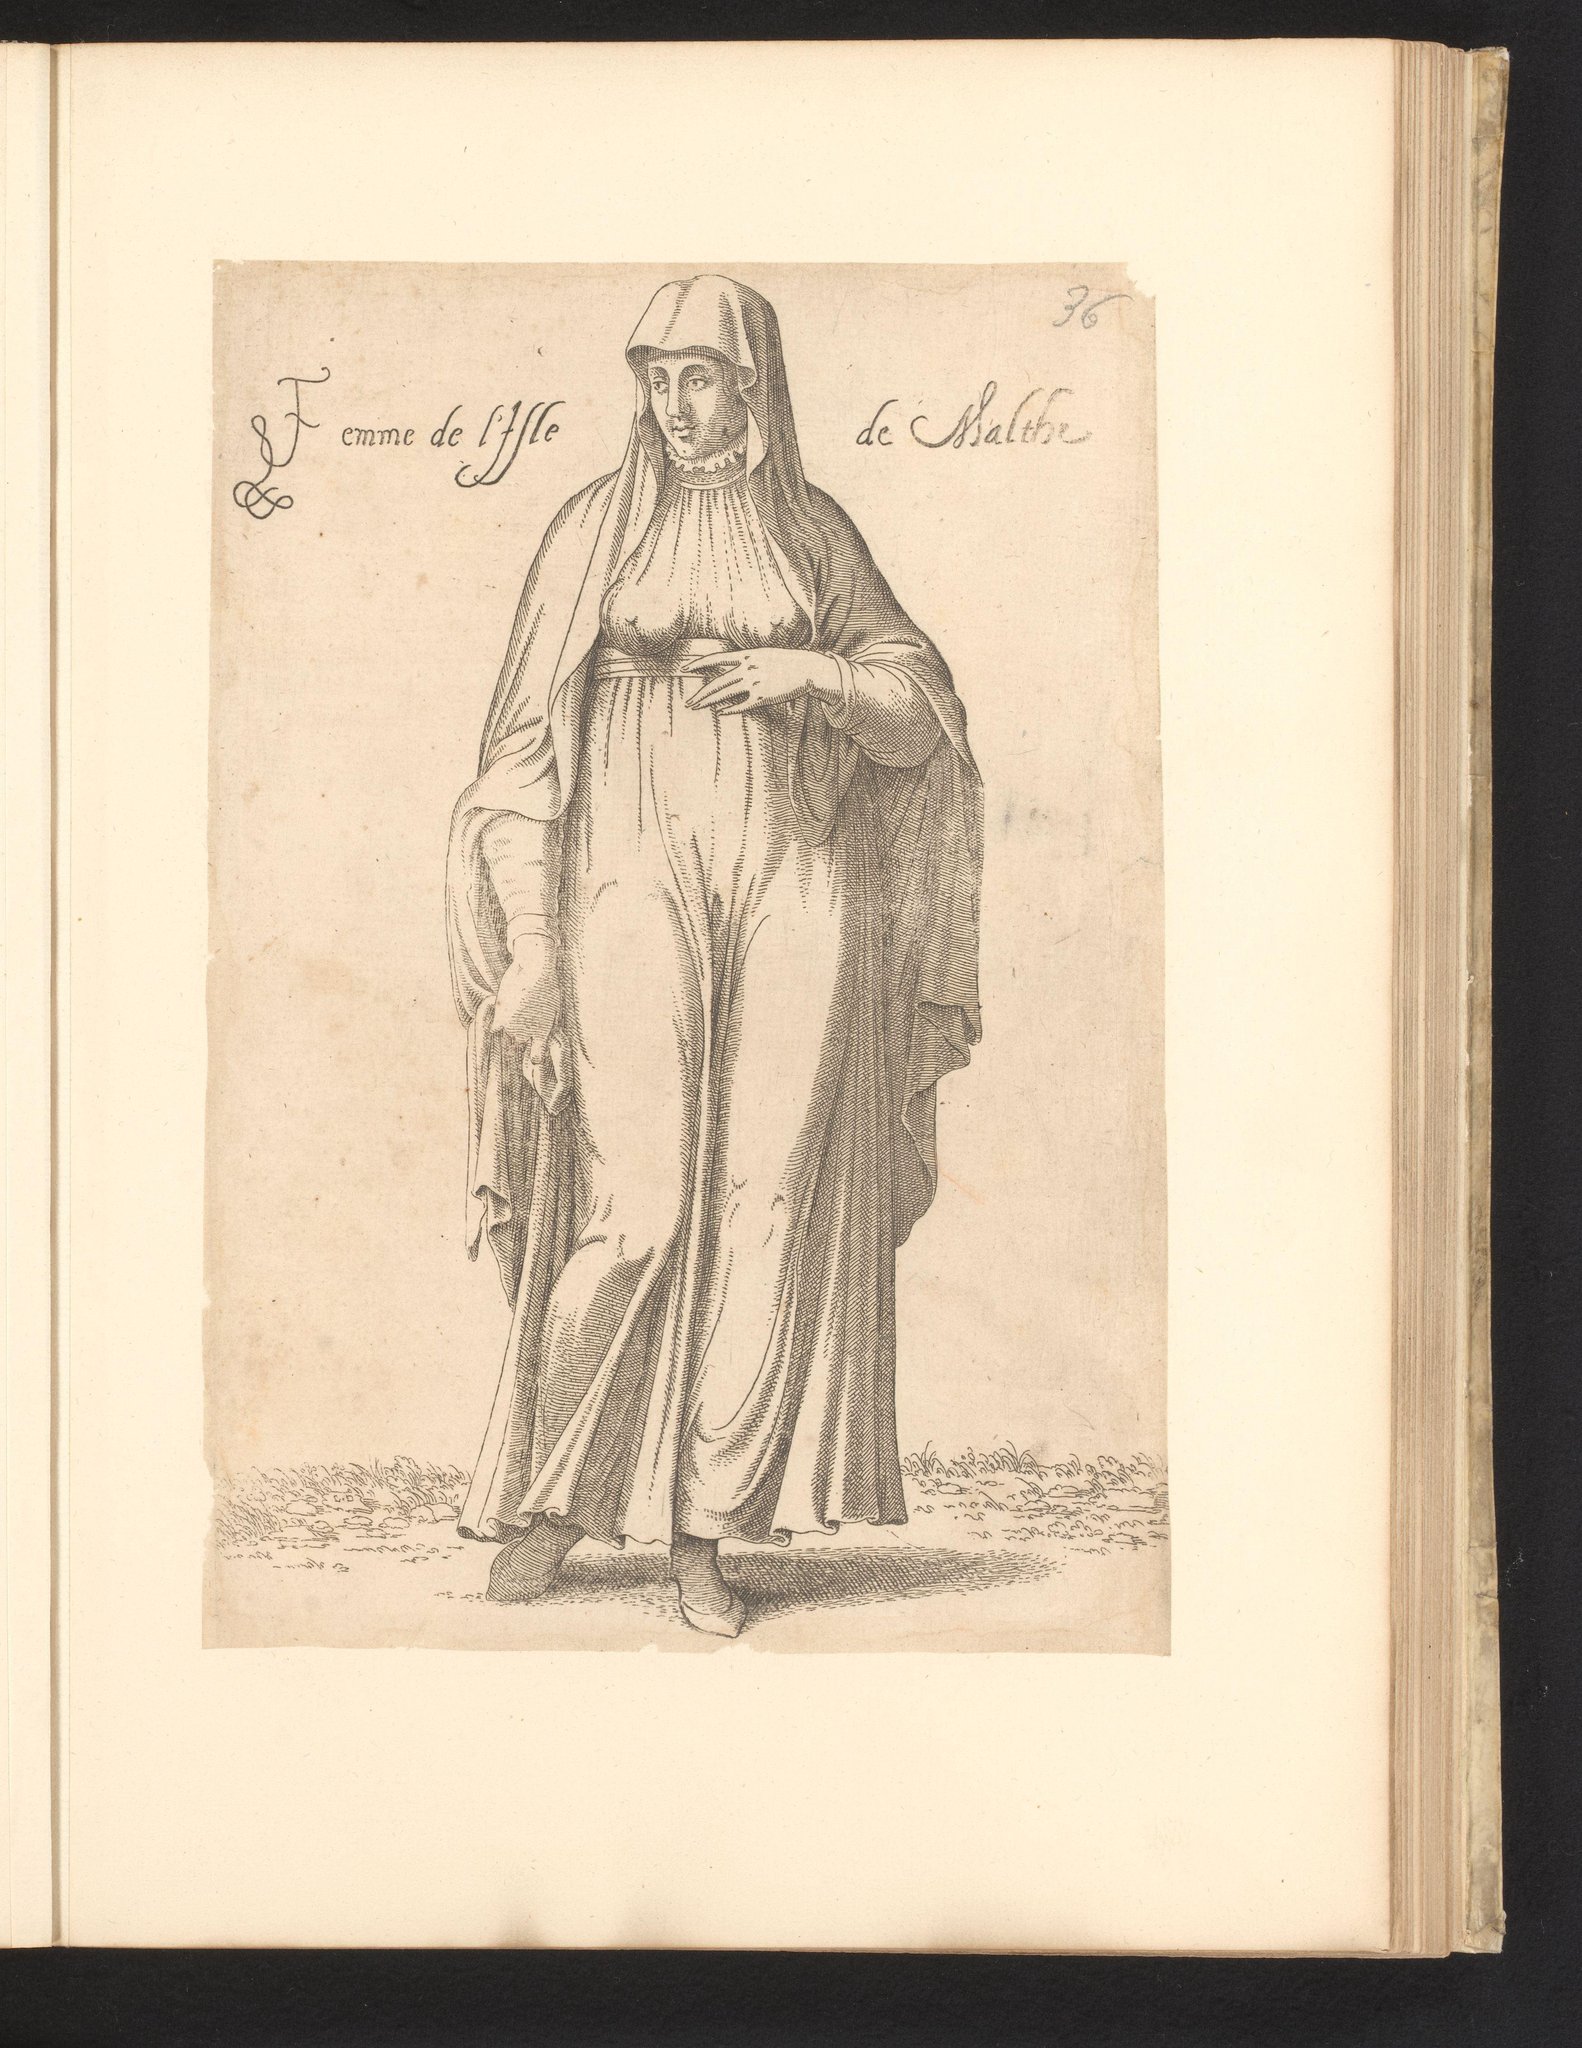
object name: album leaf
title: Vrouw afkomstig van Malta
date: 1555-1568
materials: paper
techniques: etching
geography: lyon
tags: adult woman, europeans (with name), folk costume, regional costume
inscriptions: collector's mark: Lugt 2228, collector's mark: Lugt 2760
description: Prent uit: Nicolay, Nicolas de. Les quatre premiers livres des navigations et pérégrinations orientales, de N. de Nicolay, (...) Avec les figures au naturel tant d'hommes que de femmes selon la diversité des nations, & de leur port, maintien & habitz. Lyon: Guillaume (I) Rouille, 1568.